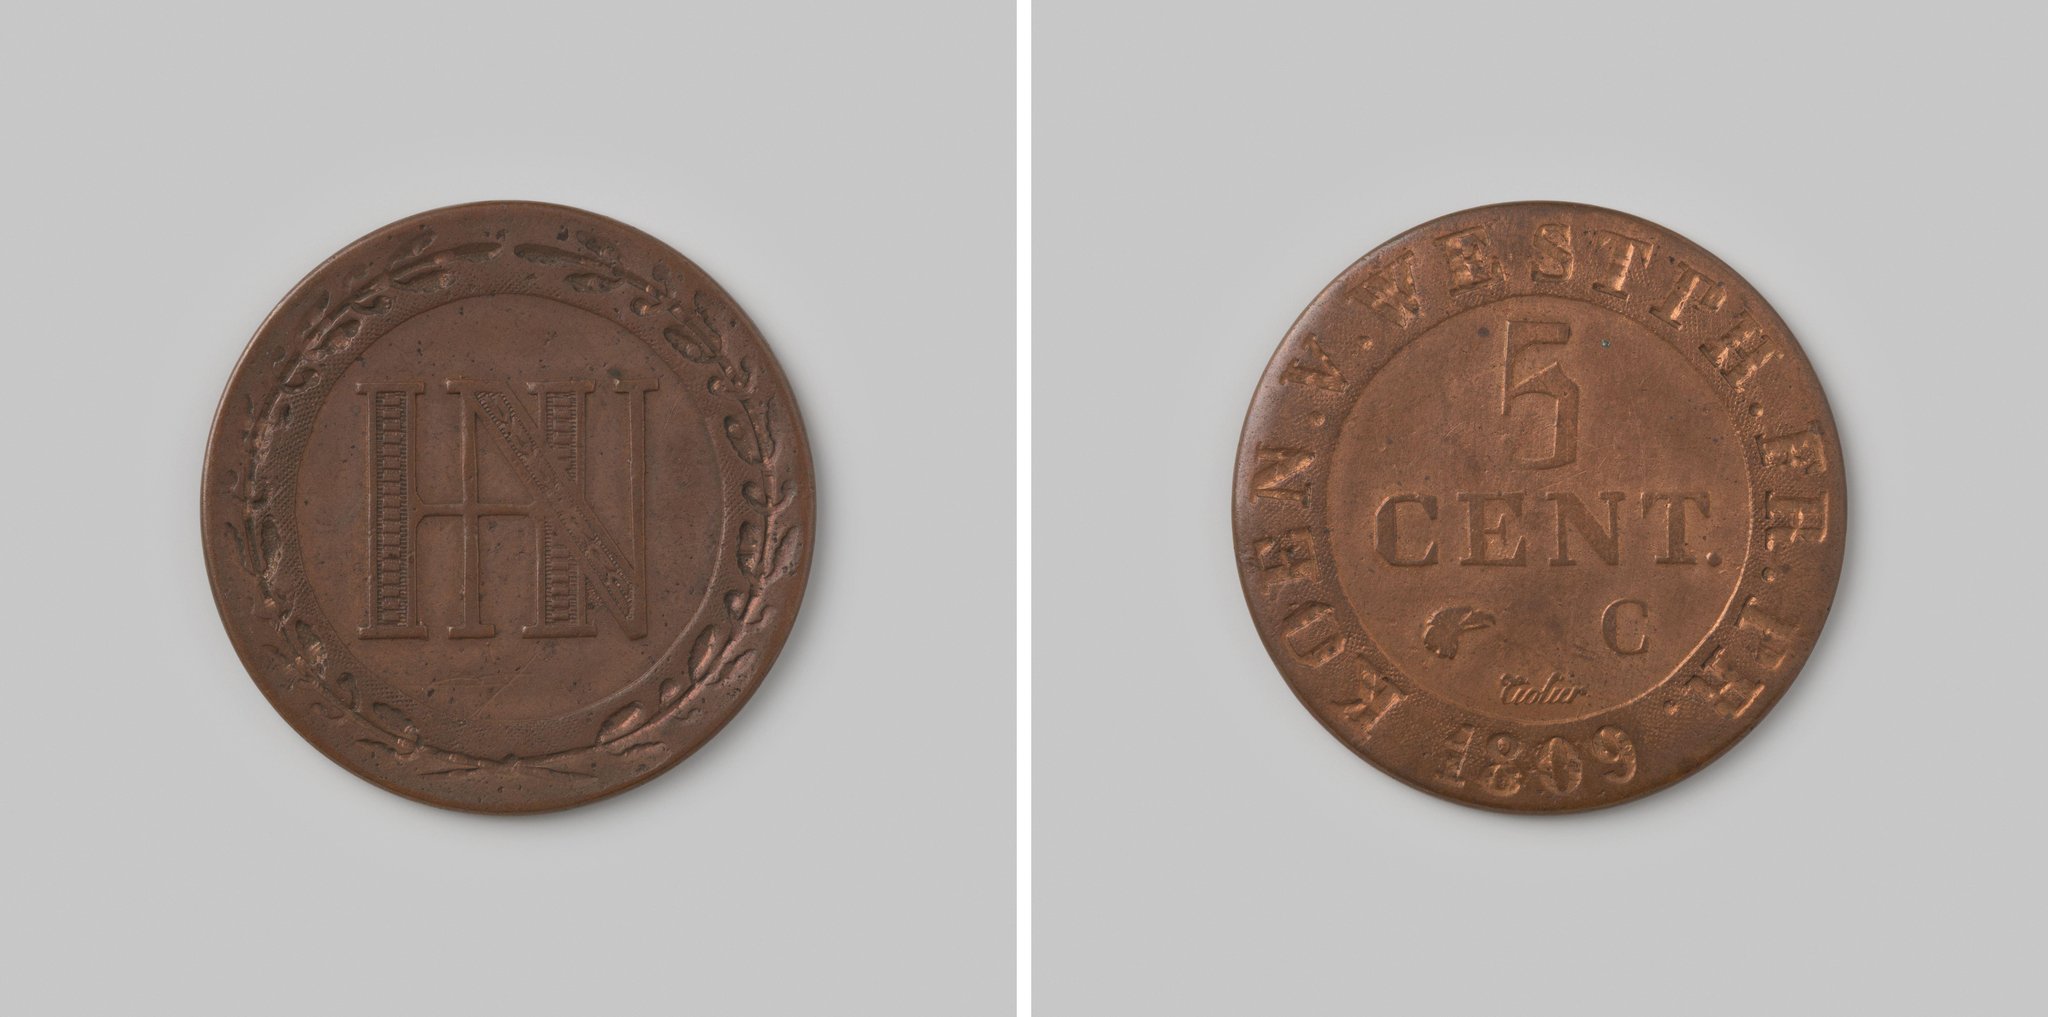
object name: vijf centime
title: 5 centimes uit het koninkrijk Westfalen van Jérome Napoléon, 1809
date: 1809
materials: copper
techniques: striking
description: Koperen munt. Voorzijde: binnen lauwerkrans monogram van de koning. Keerzijde: waarde-aanduiding in twee regels. Rechts daaronder letter C [=Kassel]. Jaartal in omschrift onderaan. Gladde rand.